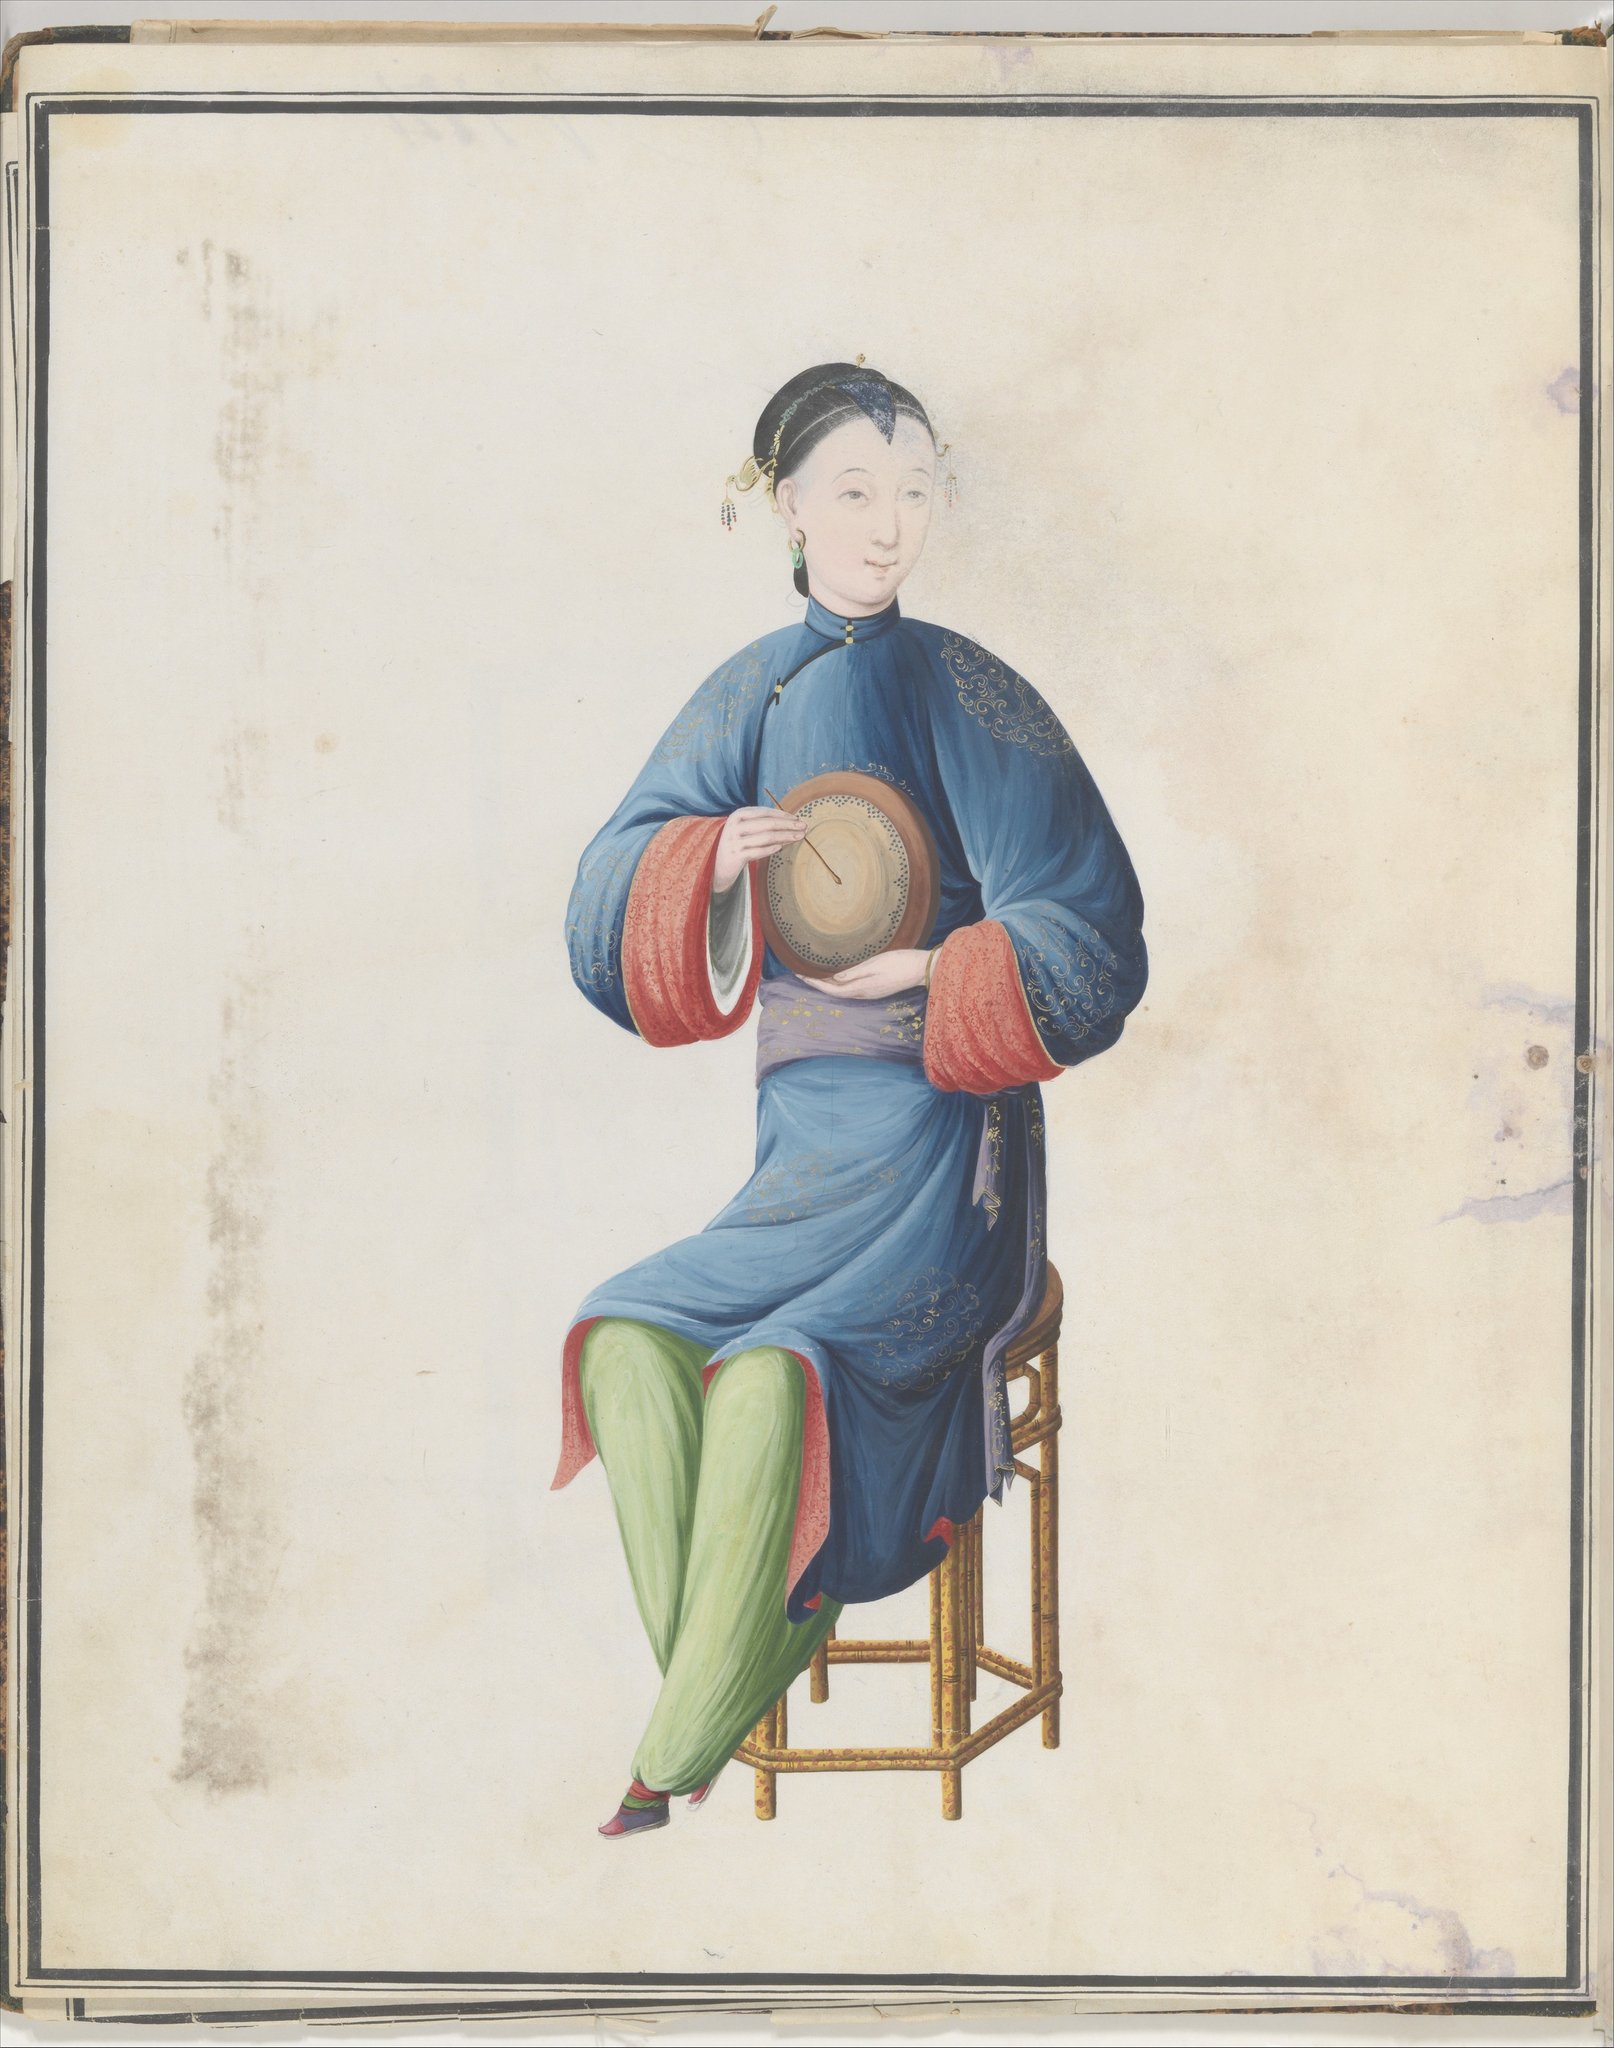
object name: watercolor of musician playing diangu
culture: chinese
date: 1767-1800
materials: paper, watercolor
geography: china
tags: musical instruments,women,musicians